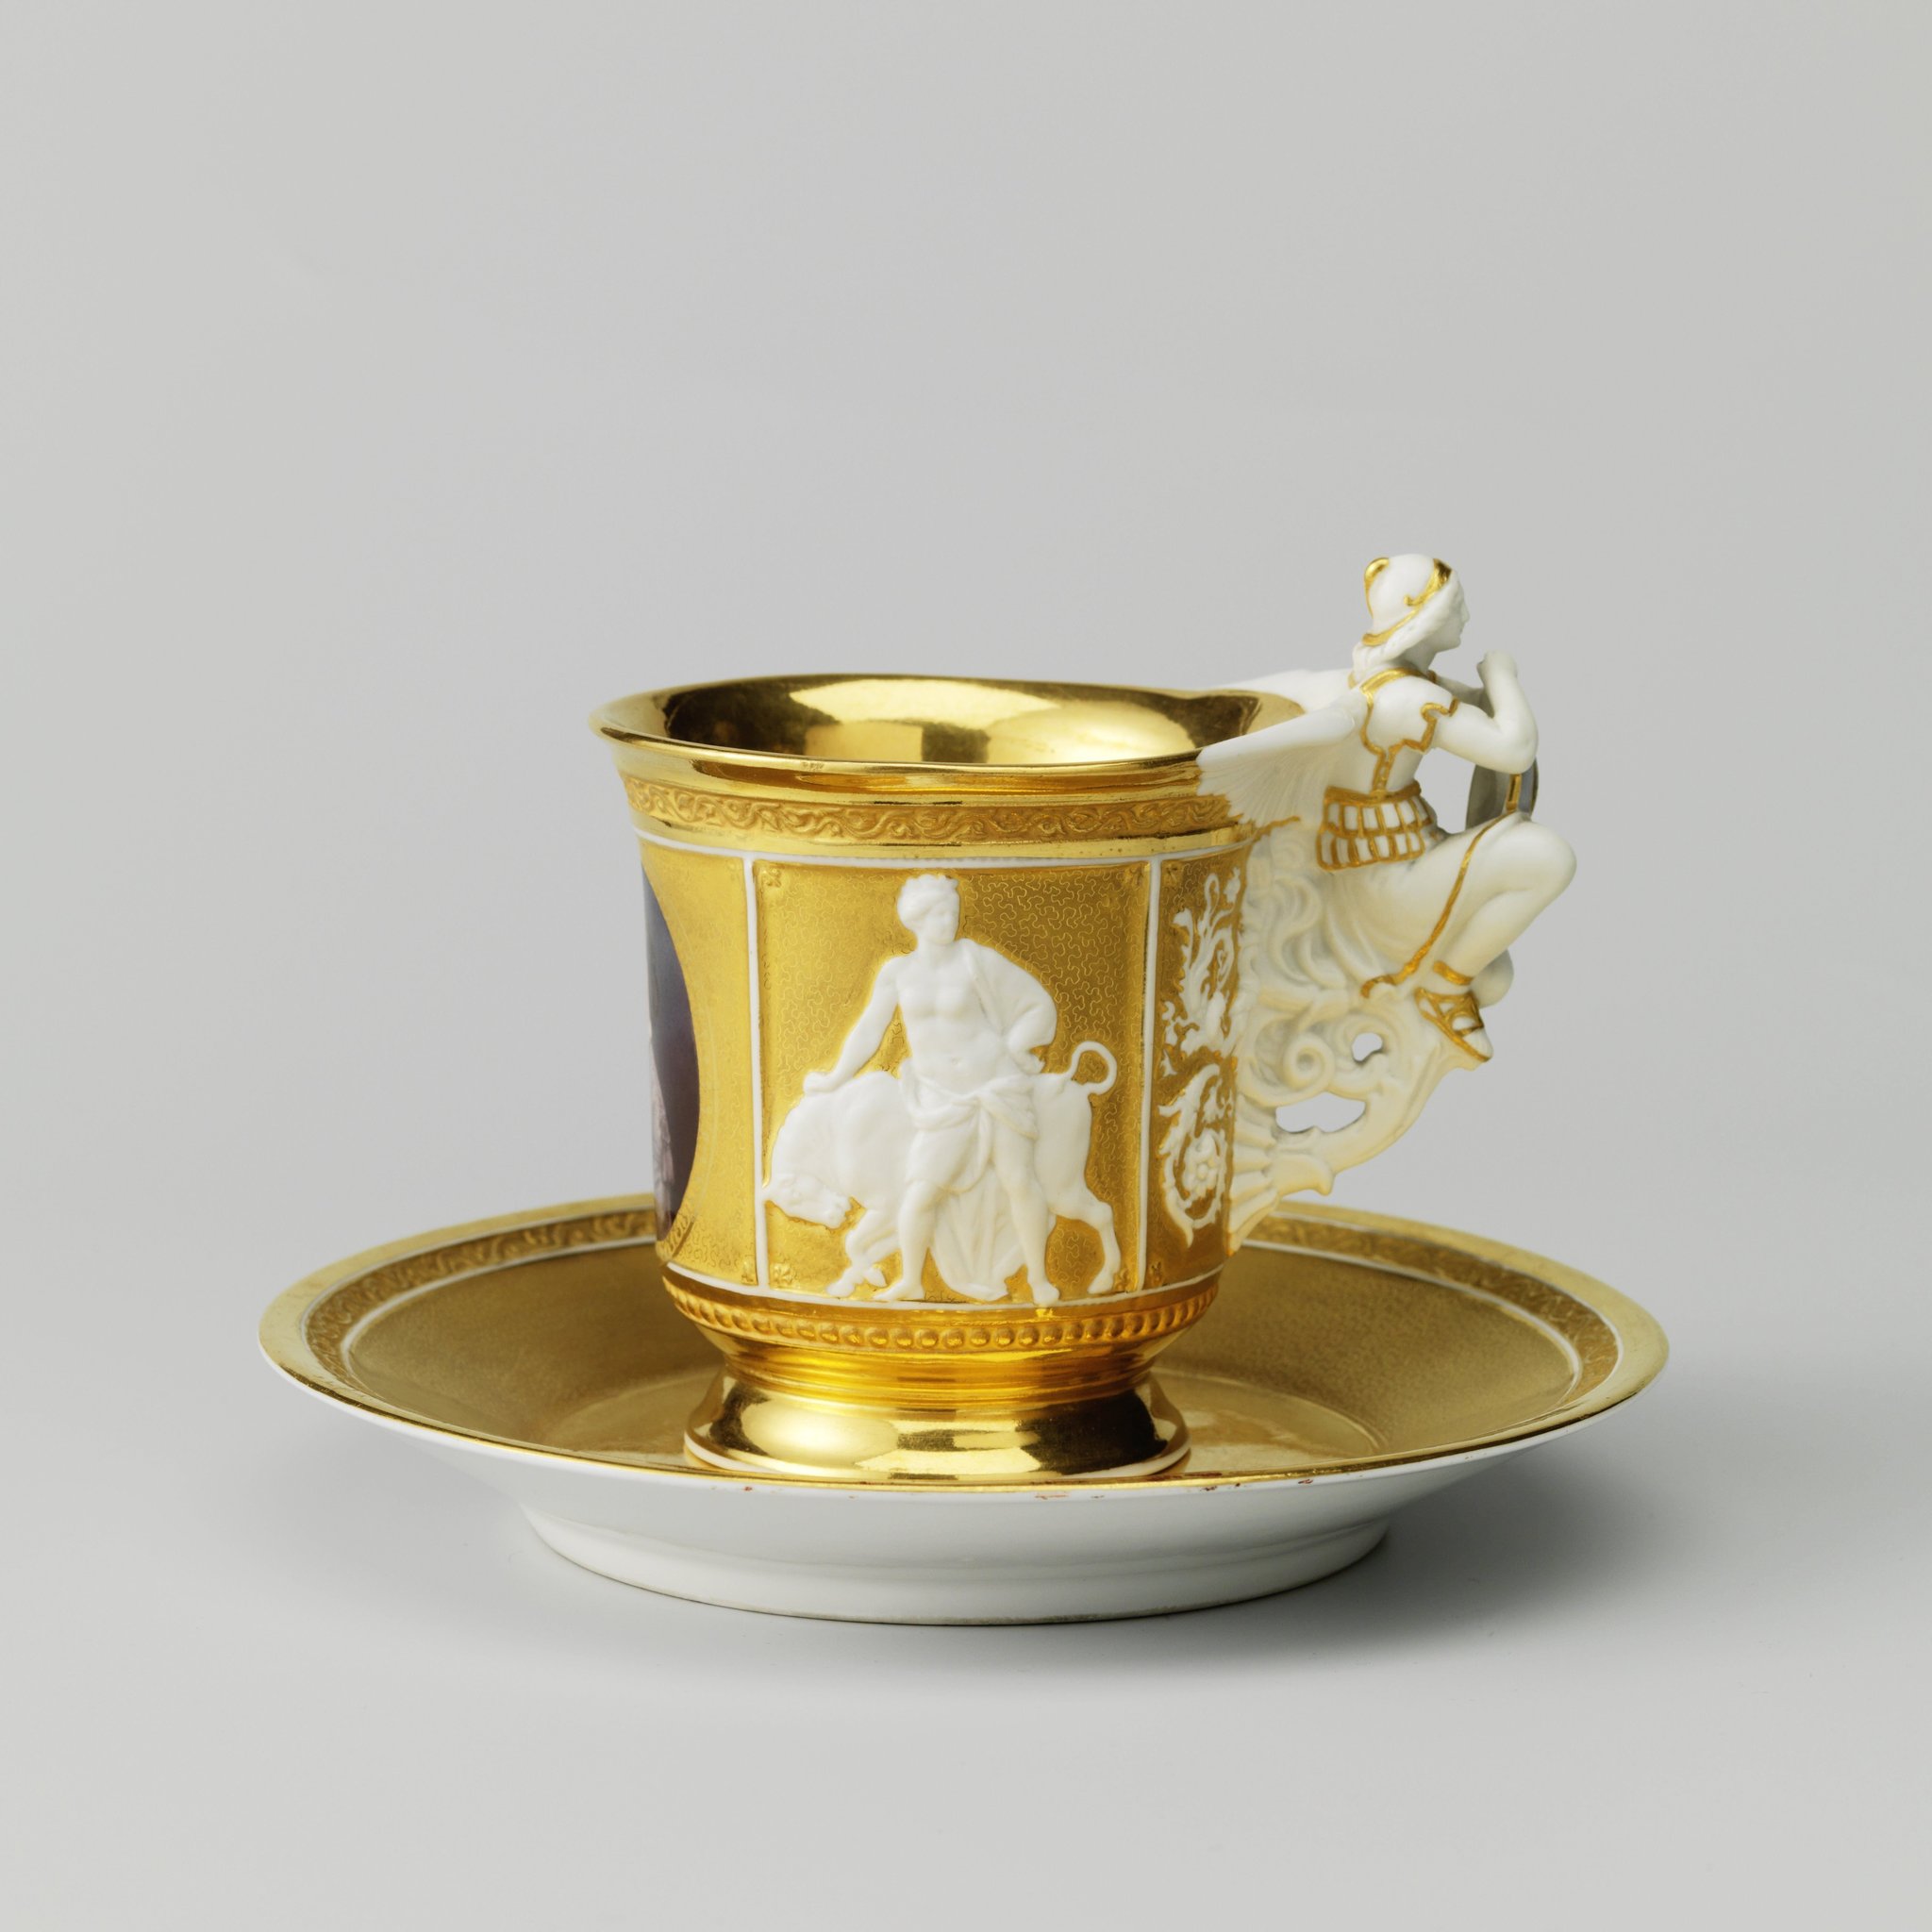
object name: kop en schotel, kop en schotel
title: Cup and saucer with the portrait of Maria van Hohenzollern-Sigmaringen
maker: a. ambronn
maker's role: painter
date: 1867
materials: glaze, gold, paint, porcelain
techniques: firing, forming, gilding, relief, turning, vitrification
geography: berlin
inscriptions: mark: ‘scepter met adelaar in medaillon en KOENIGL. PORZELLAN MANUFAKTUR/ S/ D’, signature: ‘A. Ambronn’, mark: ‘scepter met adelaar in medaillon en KOENIGL. PORZELLAN MANUFAKTUR/ M’, inscription: ‘NICHTS OHNE GOTT’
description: Two cups and saucers with portraits of Philip, Count of Flanders, and Maria von Hohenzollern-Sigmaringen. Porcelain. Berlin, Königliche Porzellan Manufaktur, ca. 1867.